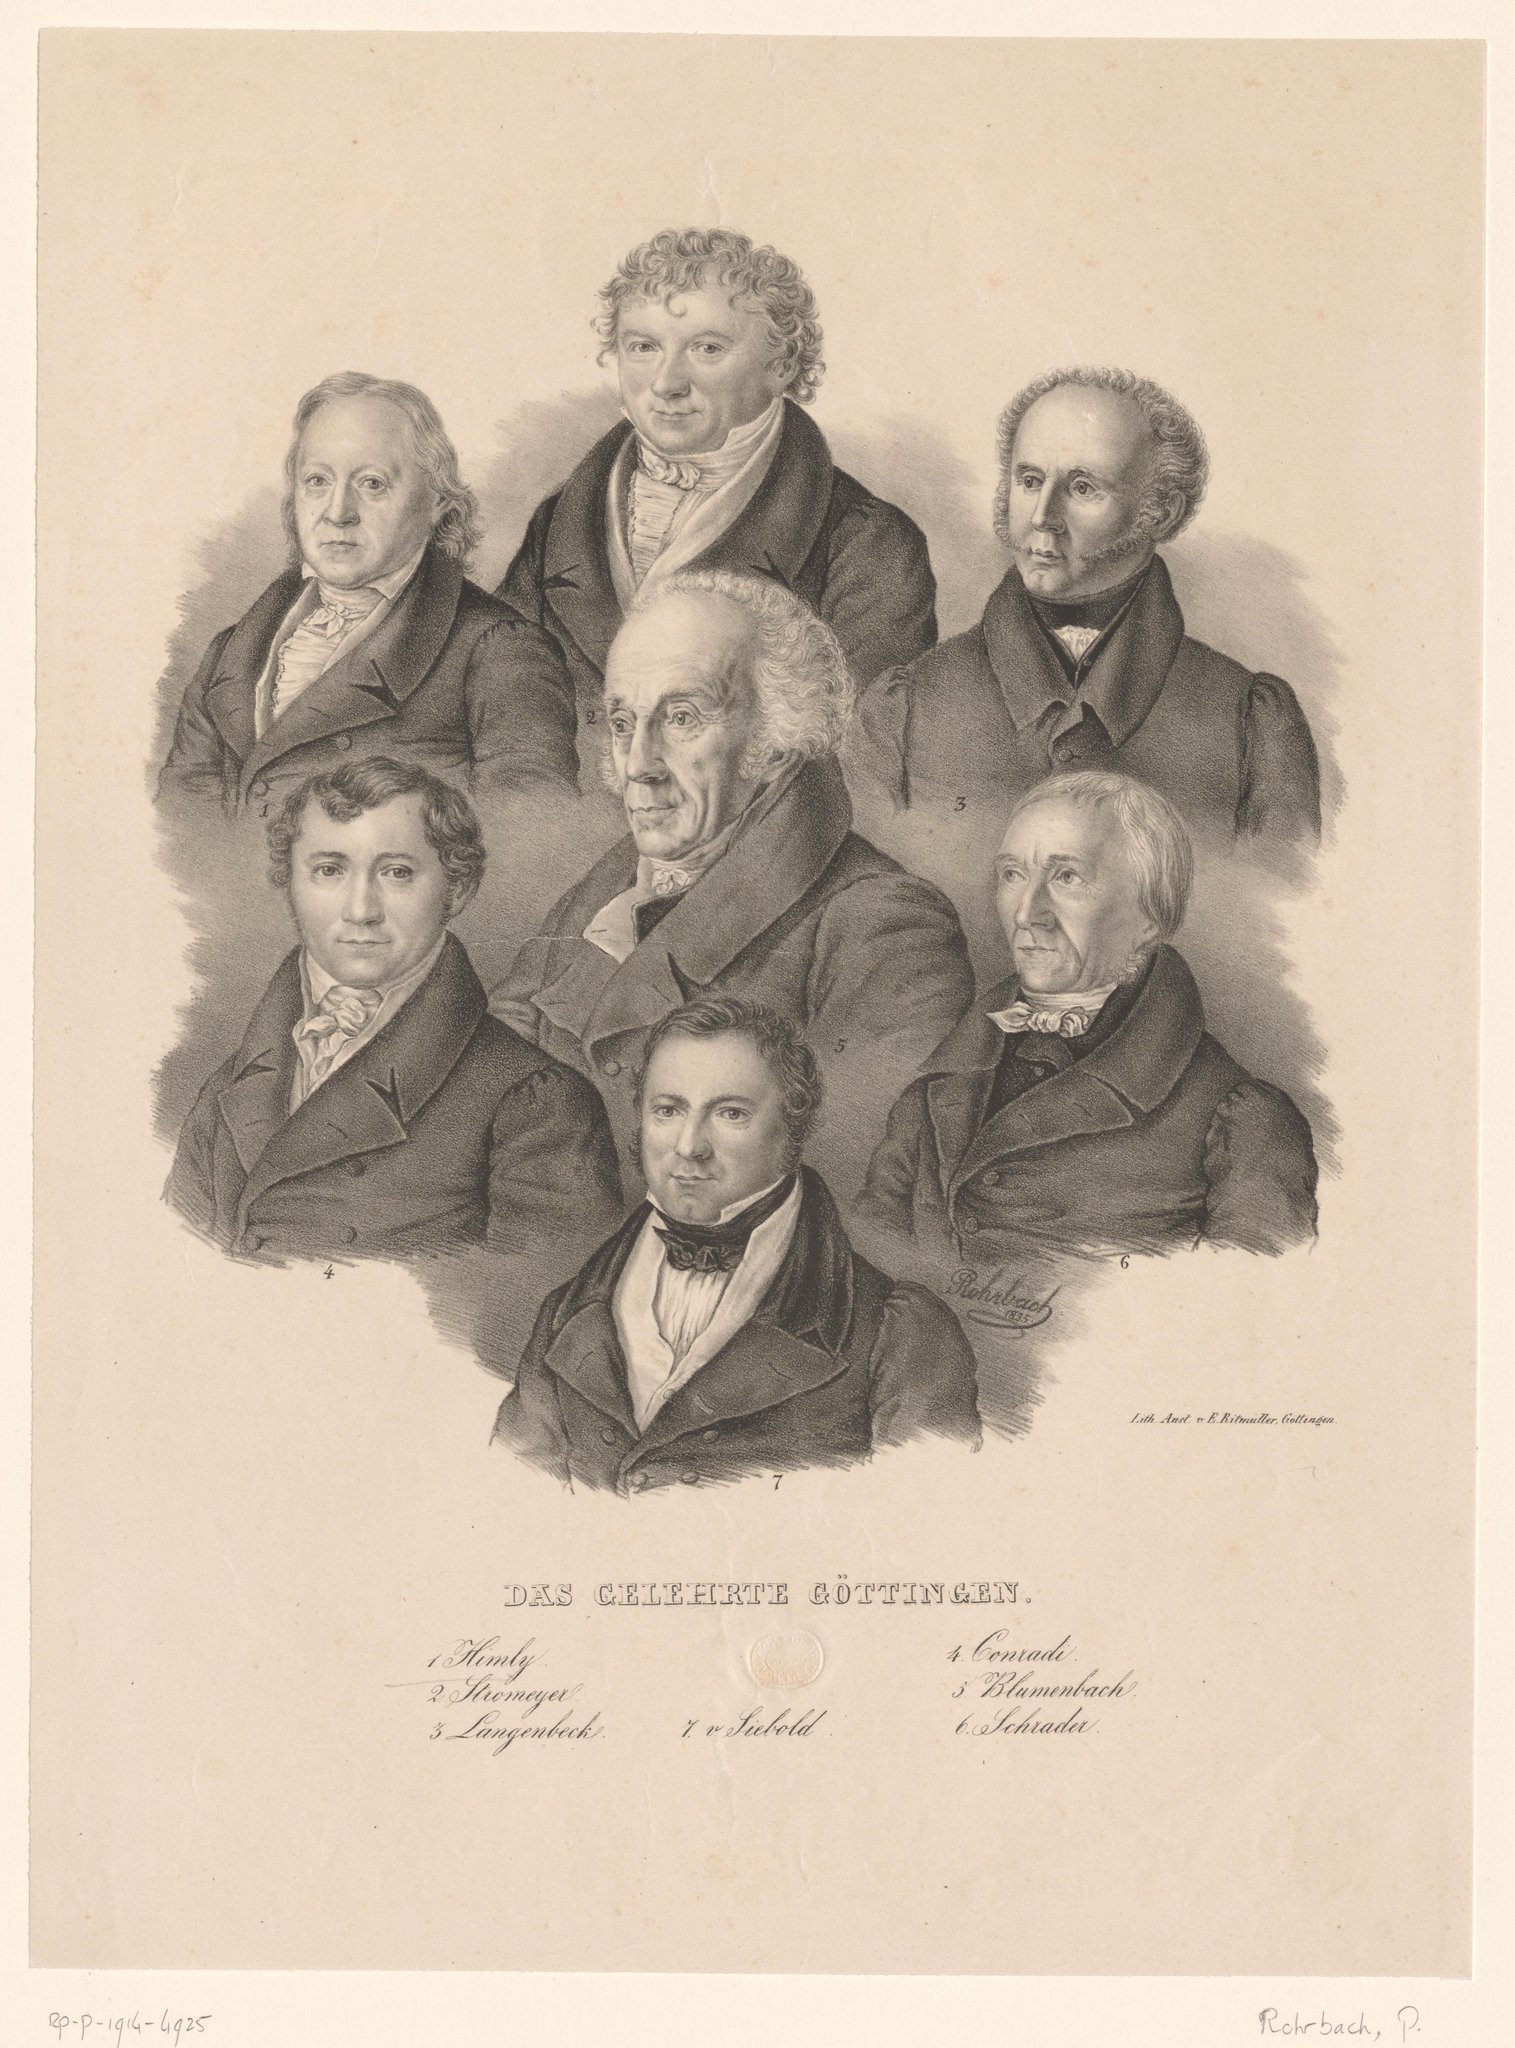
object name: print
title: Das gelehrte Göttingen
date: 1835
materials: paper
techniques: lithograph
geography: gottingen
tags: physicist, berlin, scholar, philosopher, historical persons, professor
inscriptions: workshop stamp: ‘Gebruder Rocca in Gottingen’, collector's mark: Lugt 2228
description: Portretten van Karl Gustav Himly, Friedrich Stromeyer, Conrad Johann Martin Langenbeck, Johann Wilhelm Heinrich Conradi, Johann Friedrich Blumenbach, Heinrich Adolf Schrader en Adam Elias von Siebold.